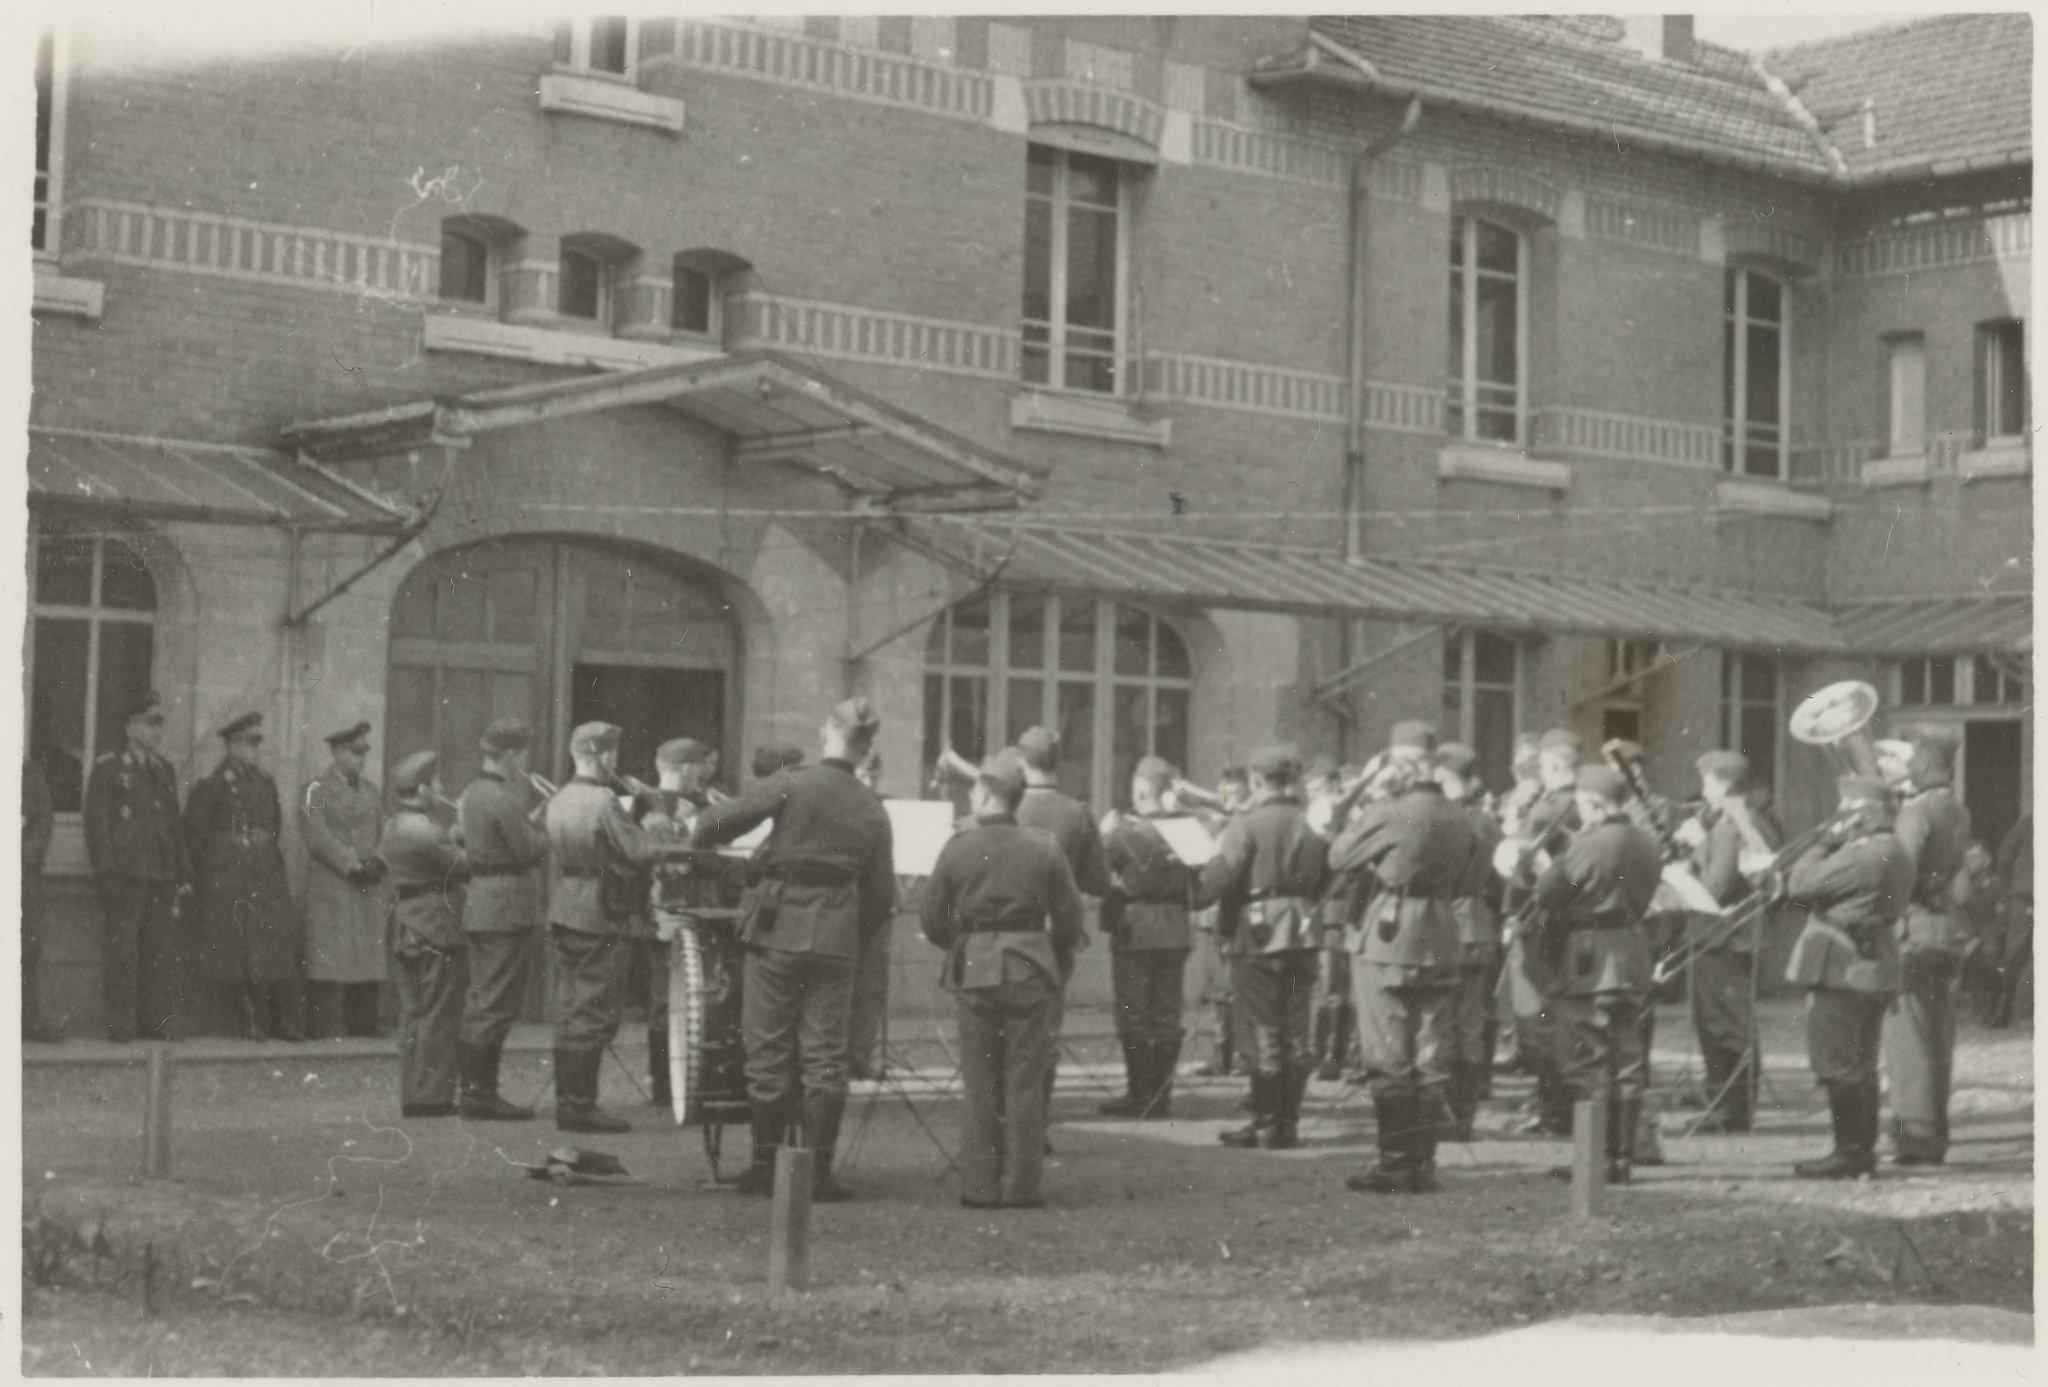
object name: photograph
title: Militaire kapel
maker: Anonymous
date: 1940-1945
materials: photographic support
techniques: gelatin silver print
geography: germany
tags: netherlands, germany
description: Een militaire kapel speelt muziek bij een groot gebouw. Mogelijk een begrafenis. Opschrift: 'Abschied von Albert'. Foto behorend bij album 'Kriegserinnerungen'.